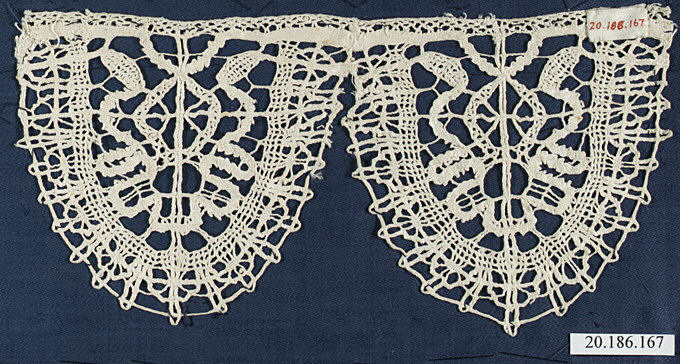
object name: edging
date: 1601-1700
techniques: lace